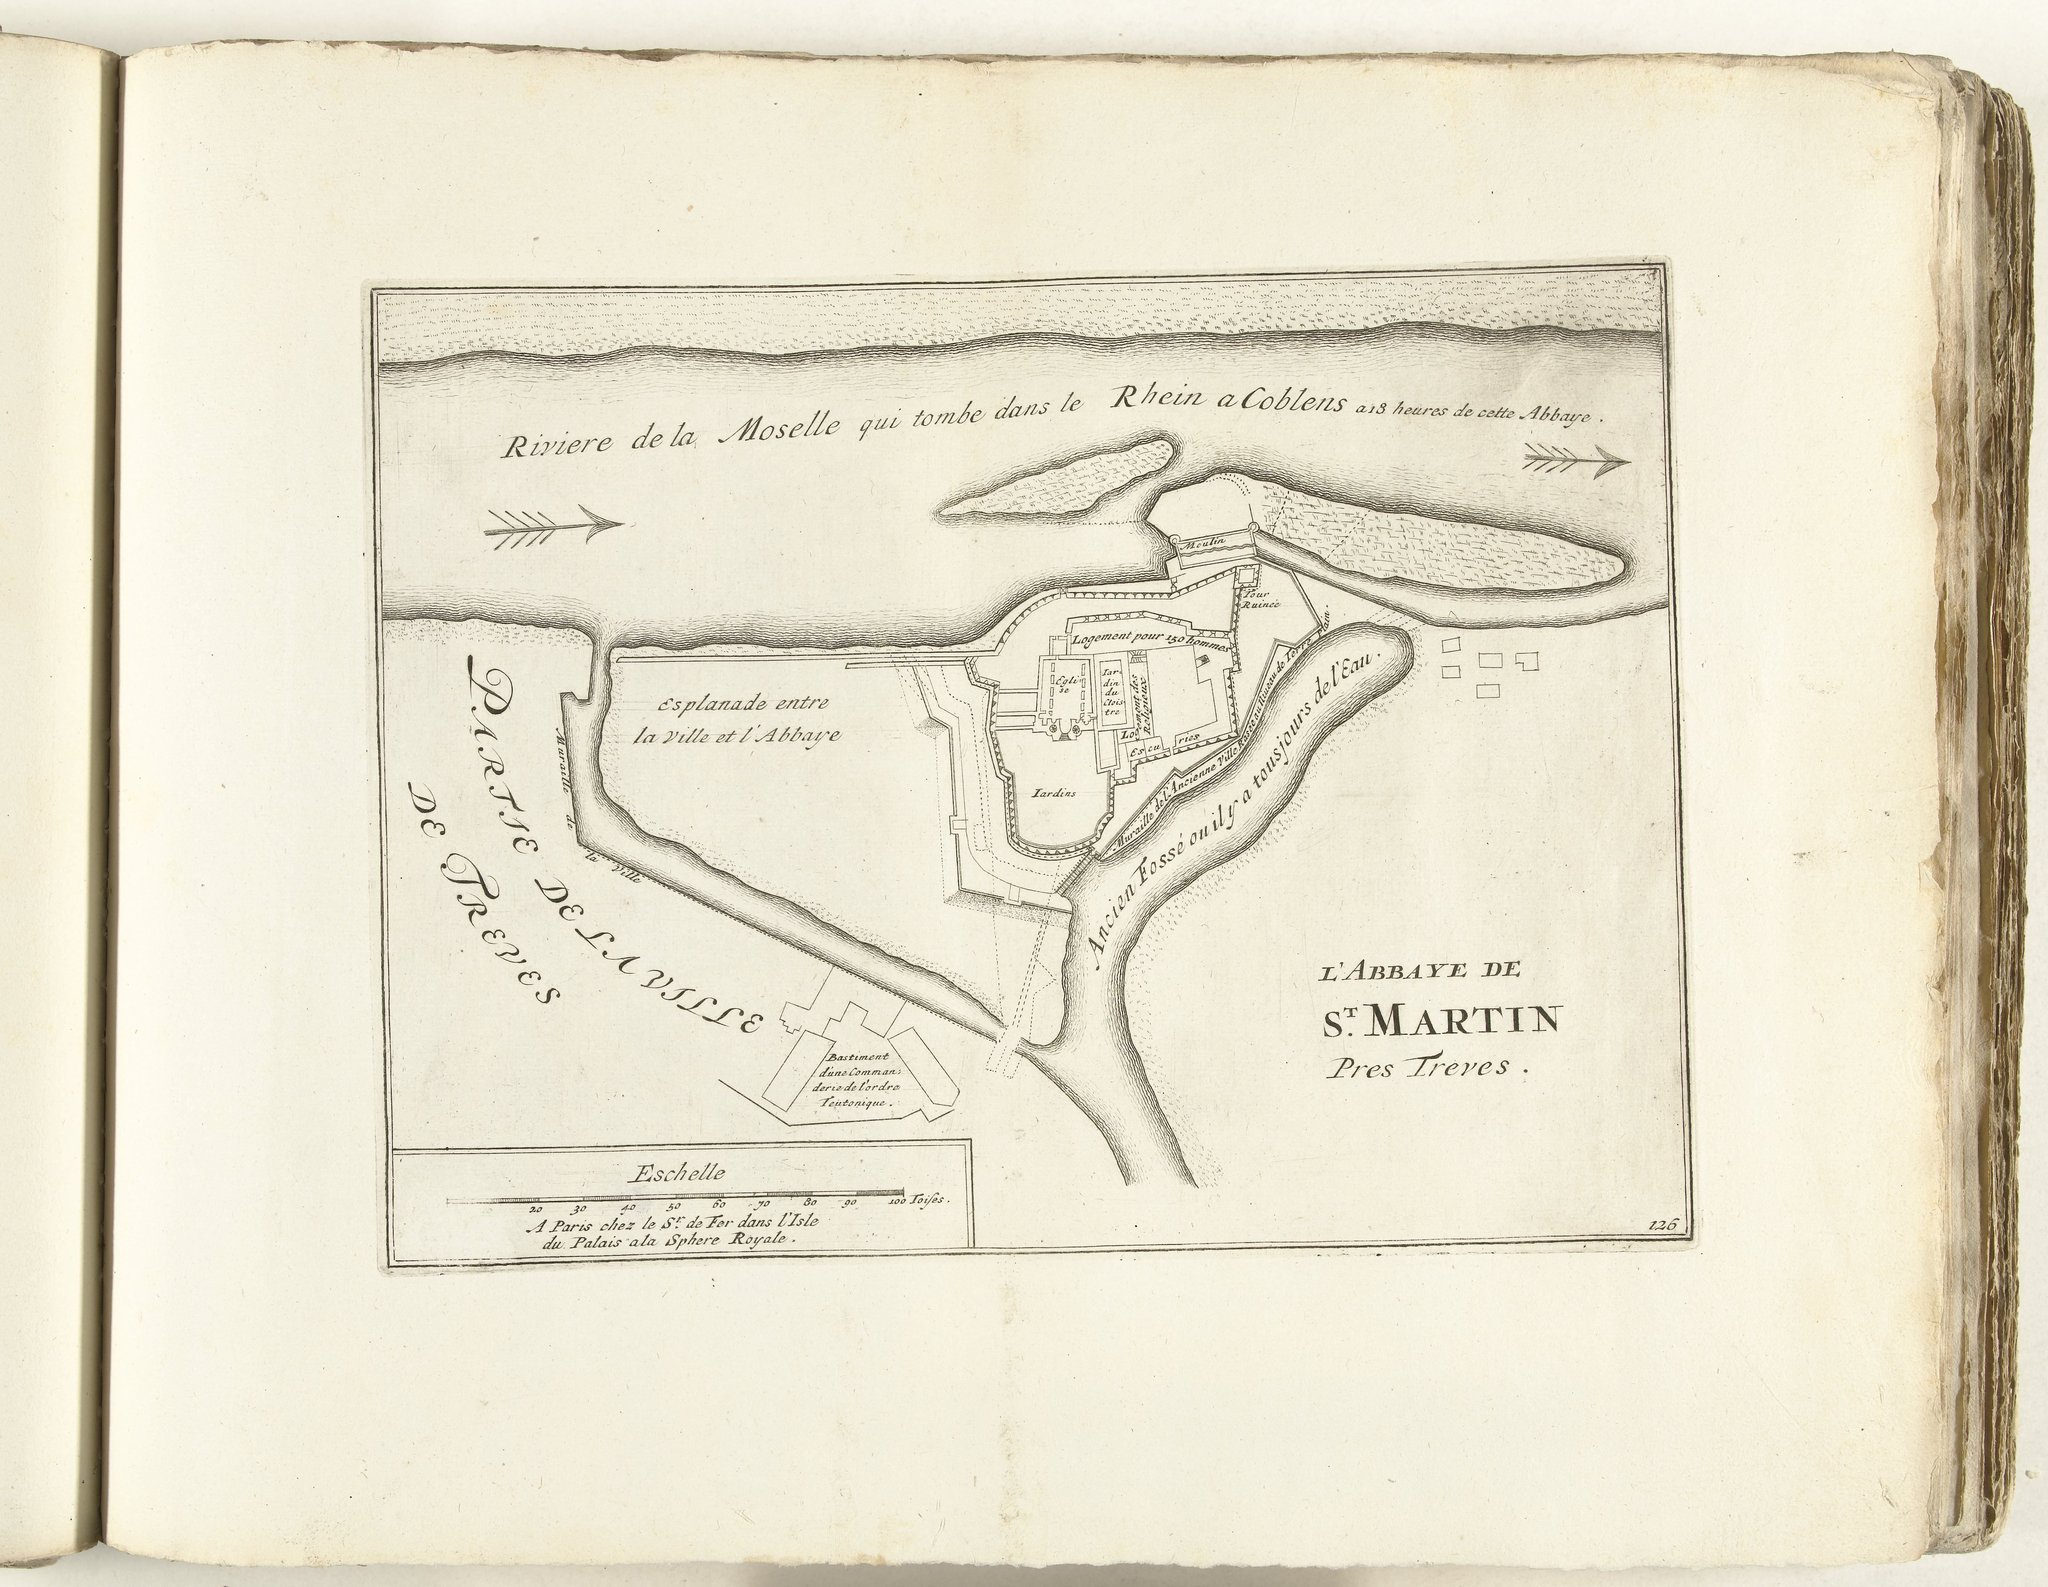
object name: print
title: Les Forces de l'Europe, Asie, Afrique et Amerique, ou description des principales villes avec leurs fortifications. Dessignées par les meilleurs ingenieurs, particulierement celles qui sont sous la domination de la France (...) et ornées de plusieurs superbes edifices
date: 1702-1703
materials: paper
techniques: etching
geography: amsterdam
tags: fortress, maps of cities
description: Plattegrond van de abdij van St. Martin bij Trier aan de Mosel. Plaat nr. 126 in het prentwerk bestaande in totaal uit 276 genummerde platen van vermaarde sterke steden en vestingen in het kader van de Spaanse Successieoorlog. Voor het merendeel zijn deze platen gekopieerd naar de anonieme Franse platen: in Les forces de l'Europe en in: Le theatre de la guerre, dans les Pays-Bas, beide oorspronkelijk uitgegeven door Nicolas de Fer te Parijs (1693-1697) in het kader van de Negenjarige Oorlog. Titel en opschriften in de plaat in het Frans.